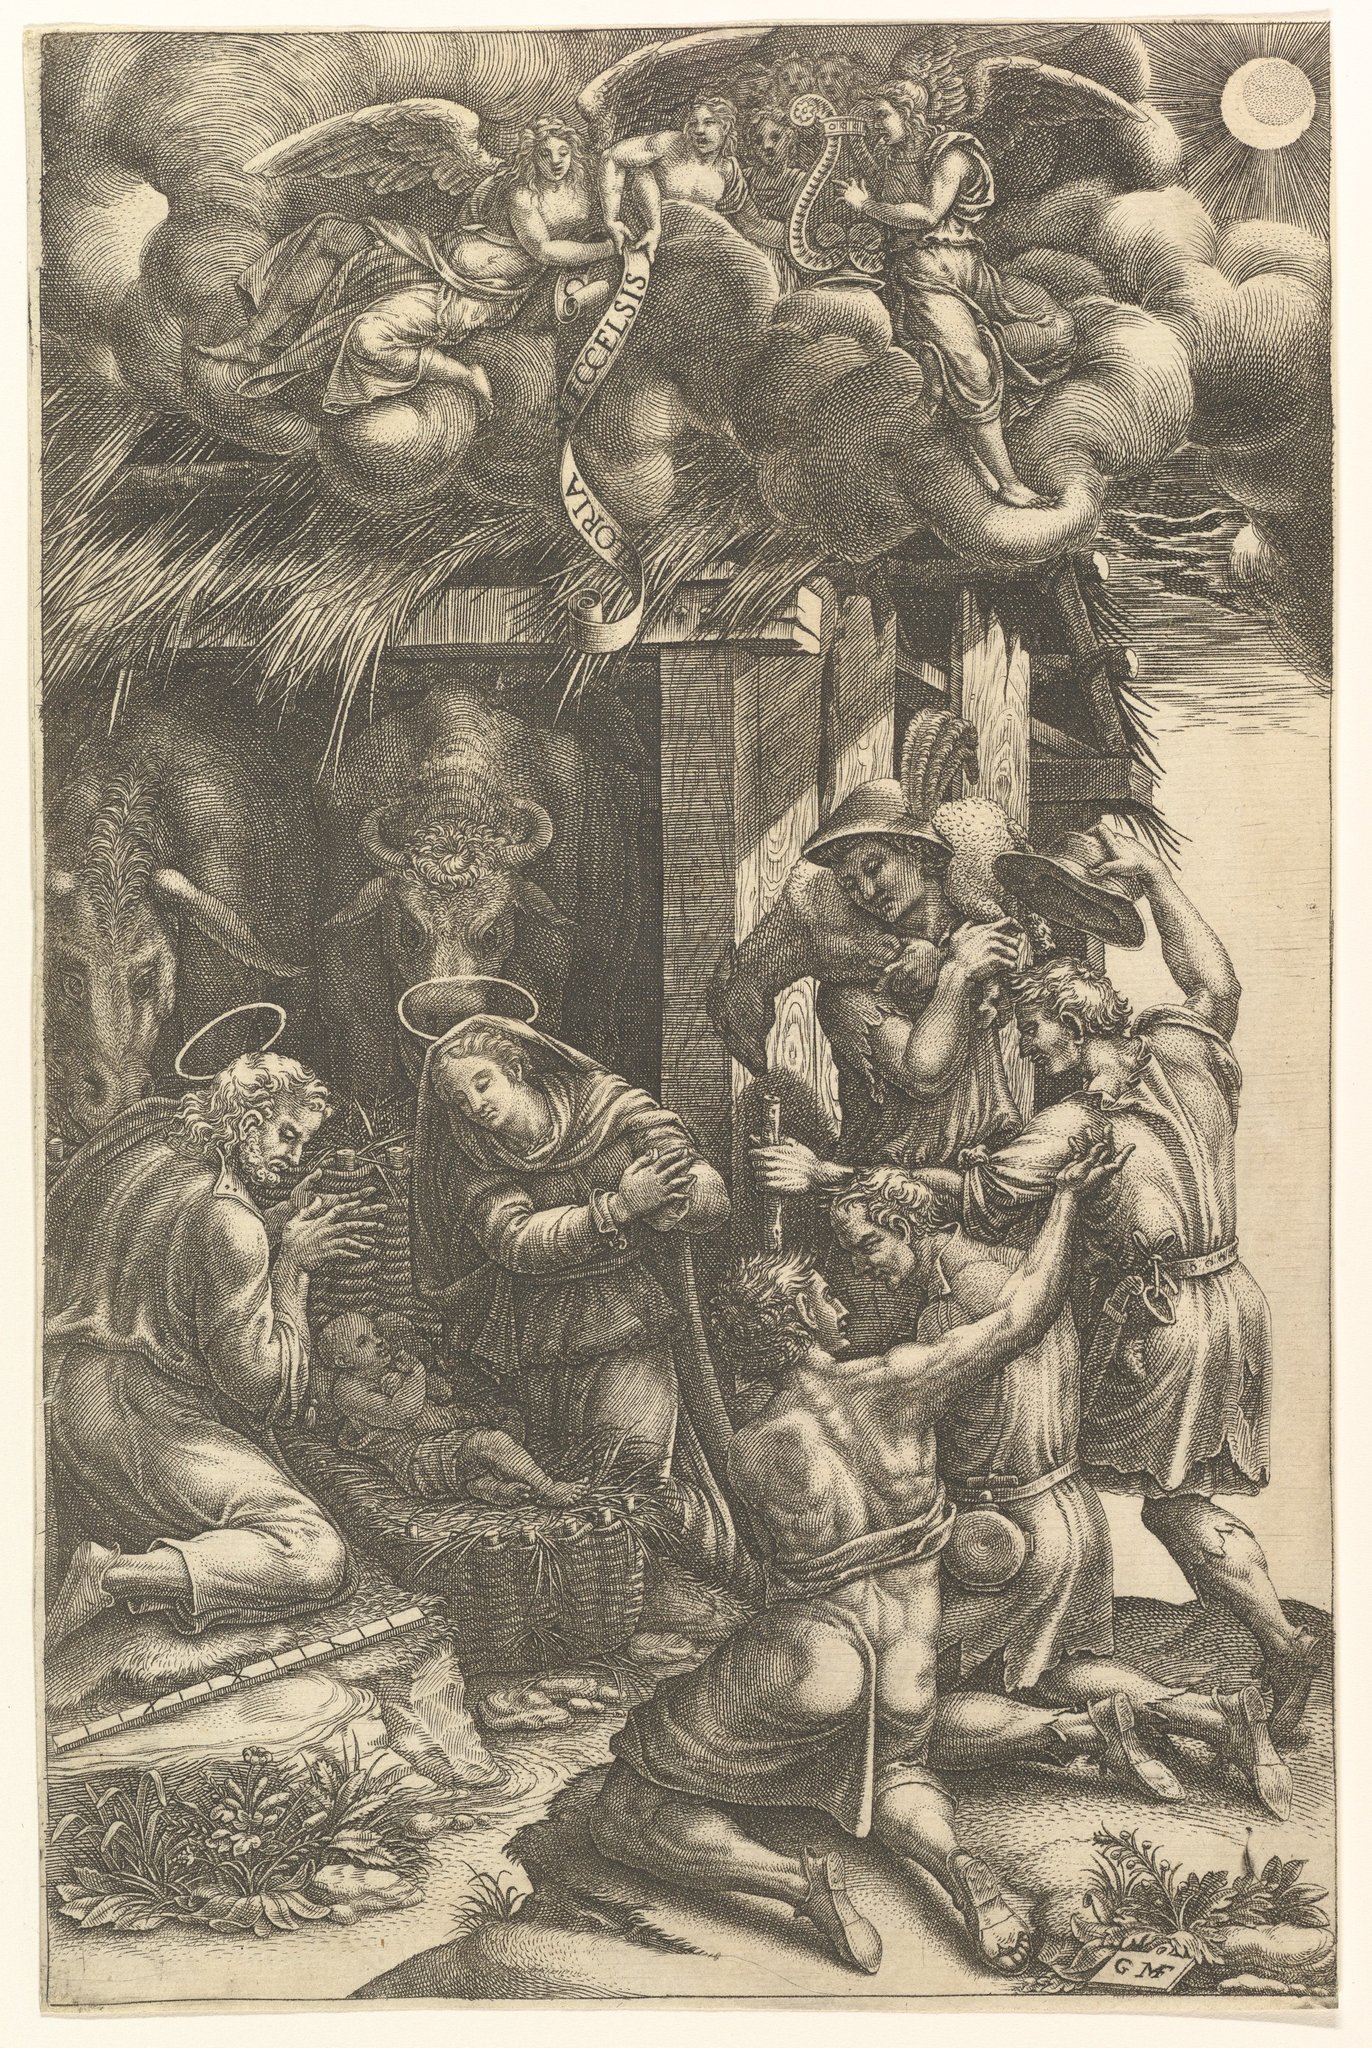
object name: print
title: The Adoration of the Shepherds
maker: giorgio ghisi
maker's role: artist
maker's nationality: italian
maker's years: 1515-1582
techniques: engraving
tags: men,angels,virgin mary,jesus,adoration of the shepherds